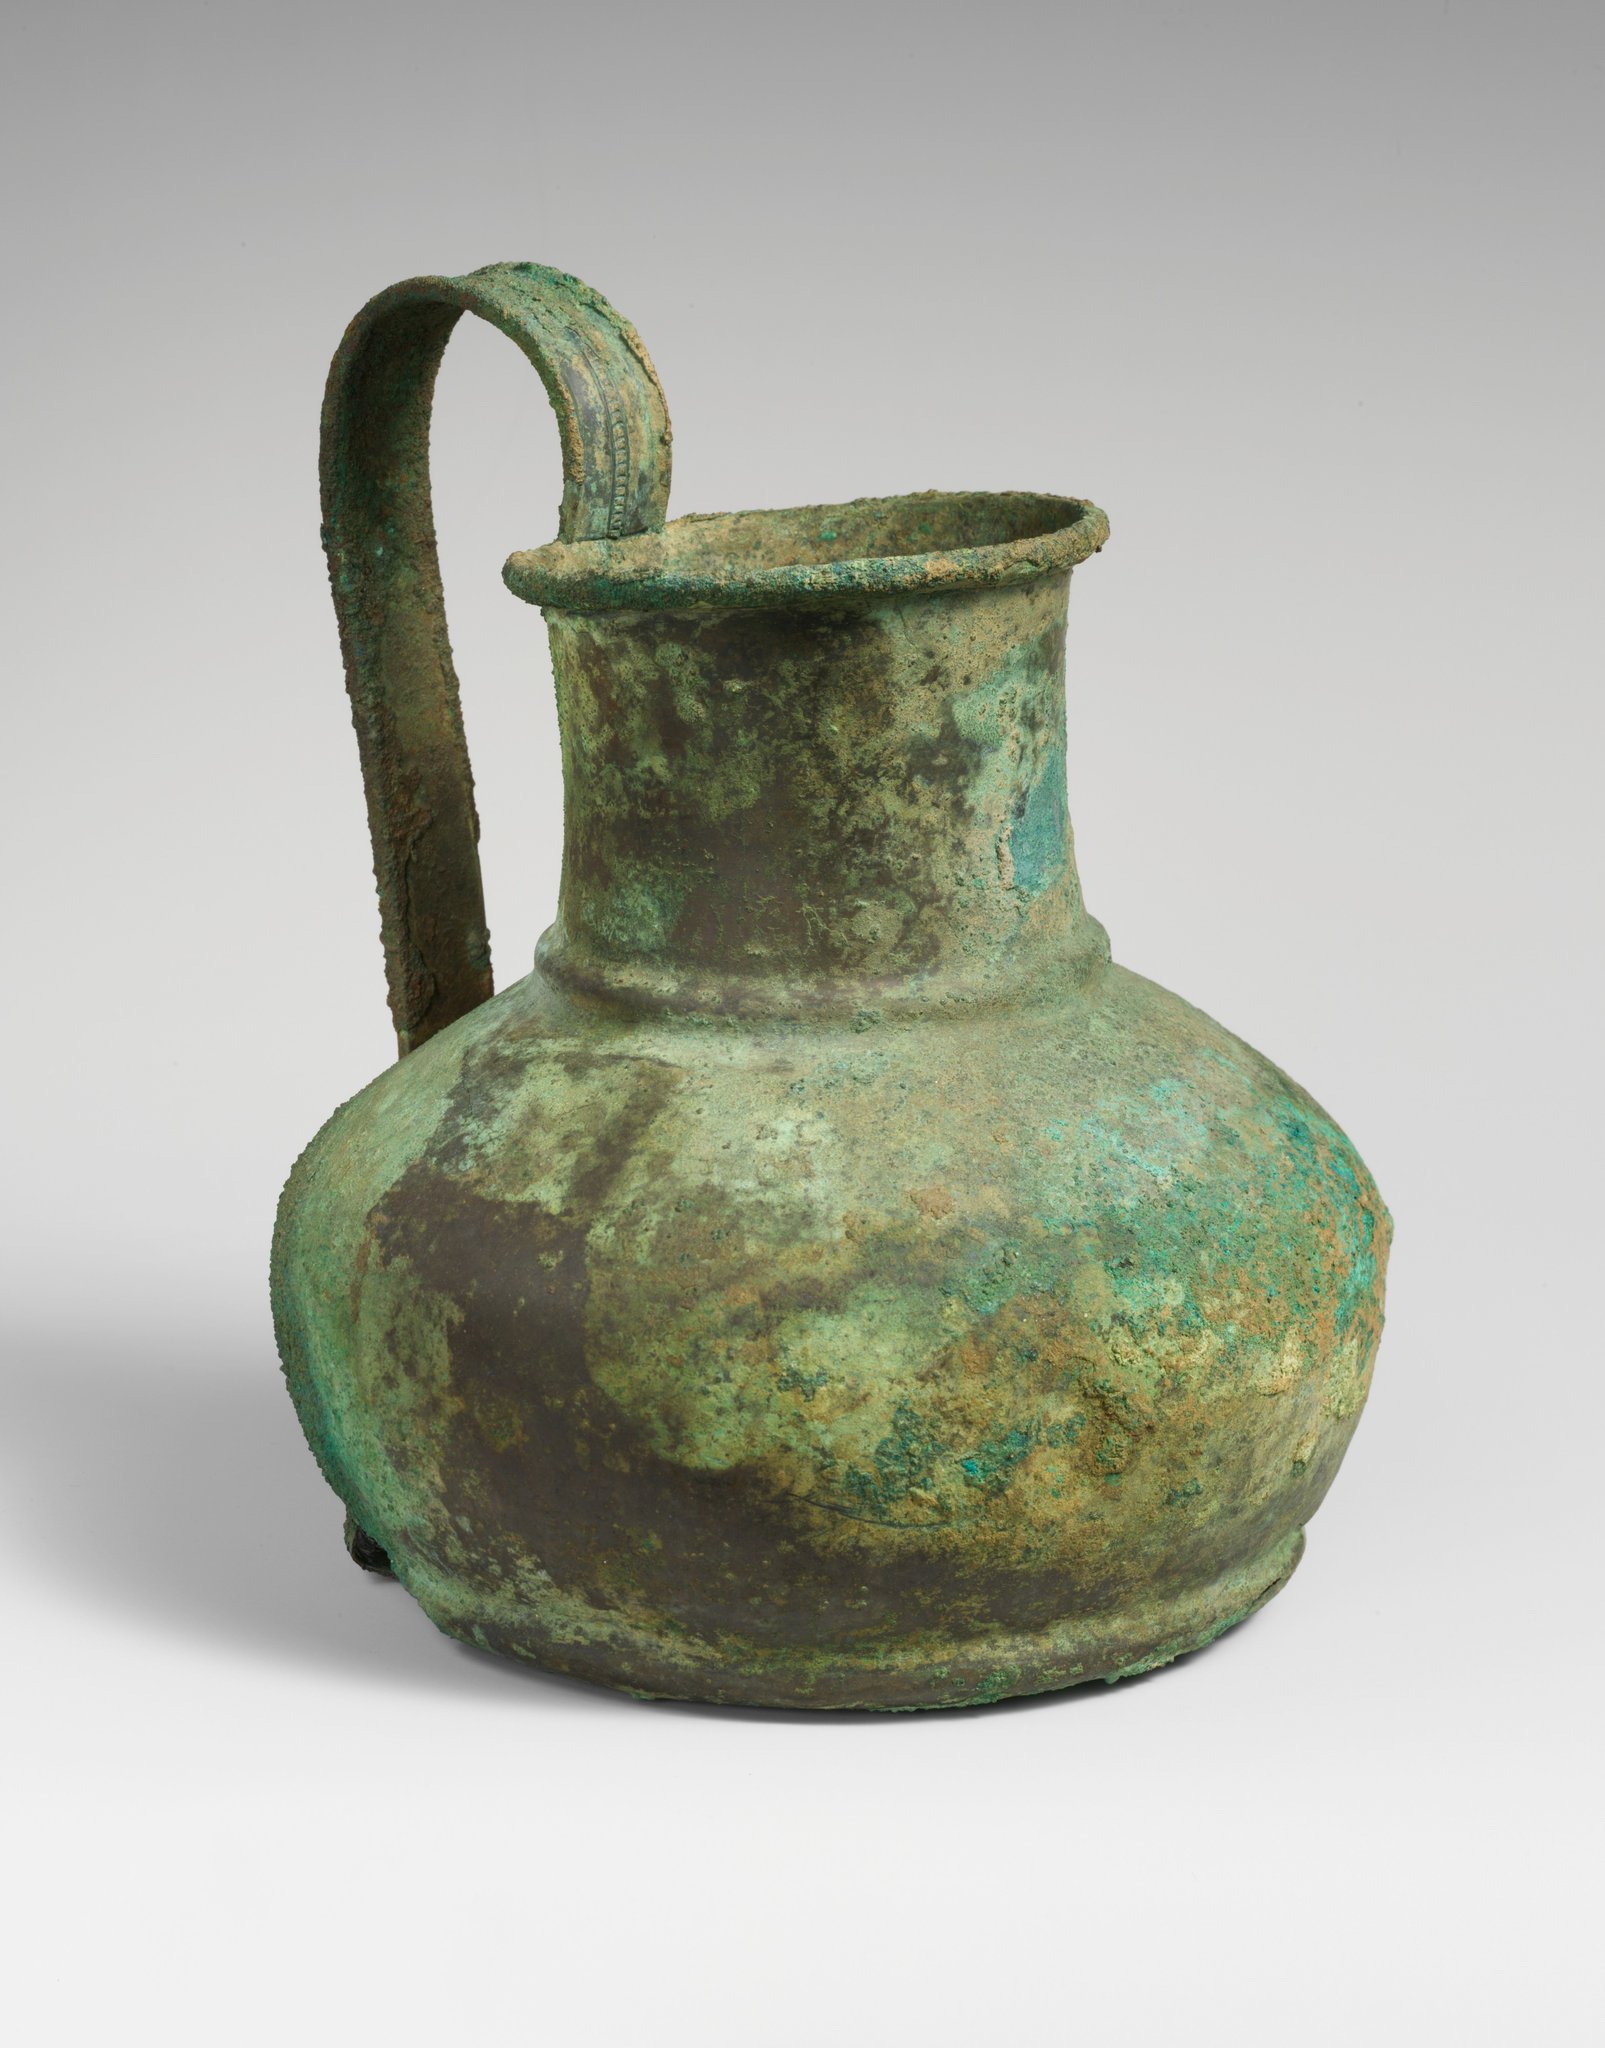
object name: jug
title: Bronze jug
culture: lydian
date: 201-300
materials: bronze